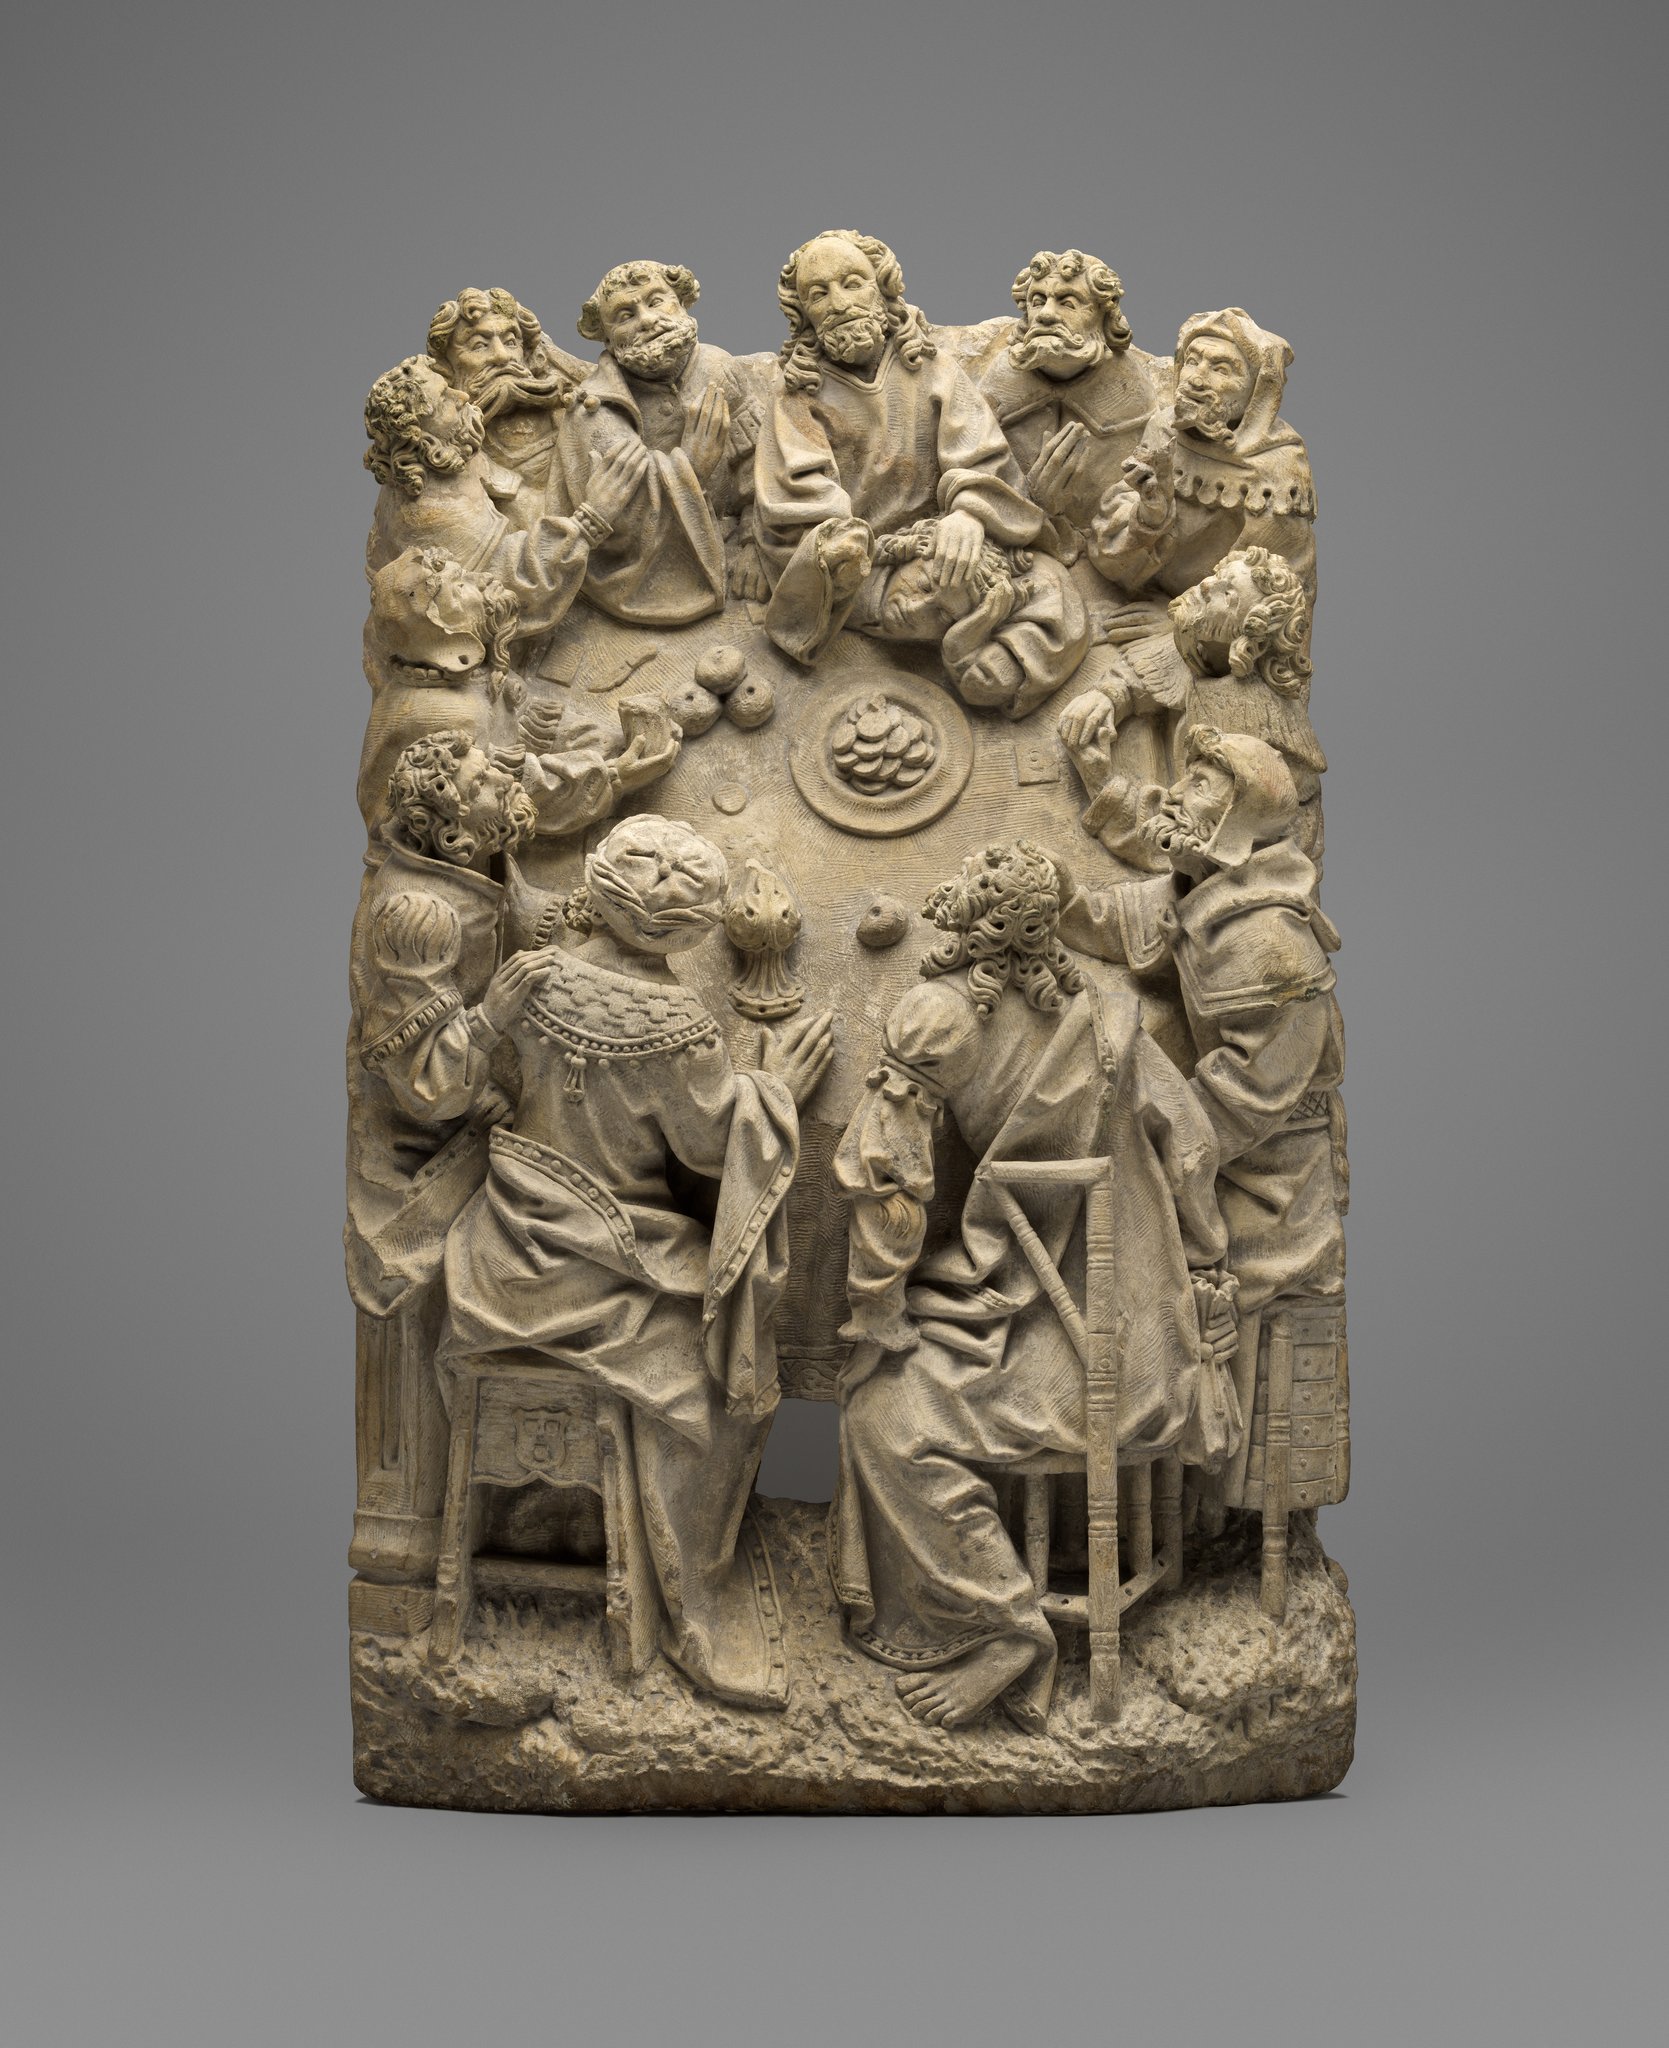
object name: relief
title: The Last Supper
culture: german or south netherlandish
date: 1500-1530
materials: limestone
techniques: polychromy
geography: germany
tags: apostles,christ